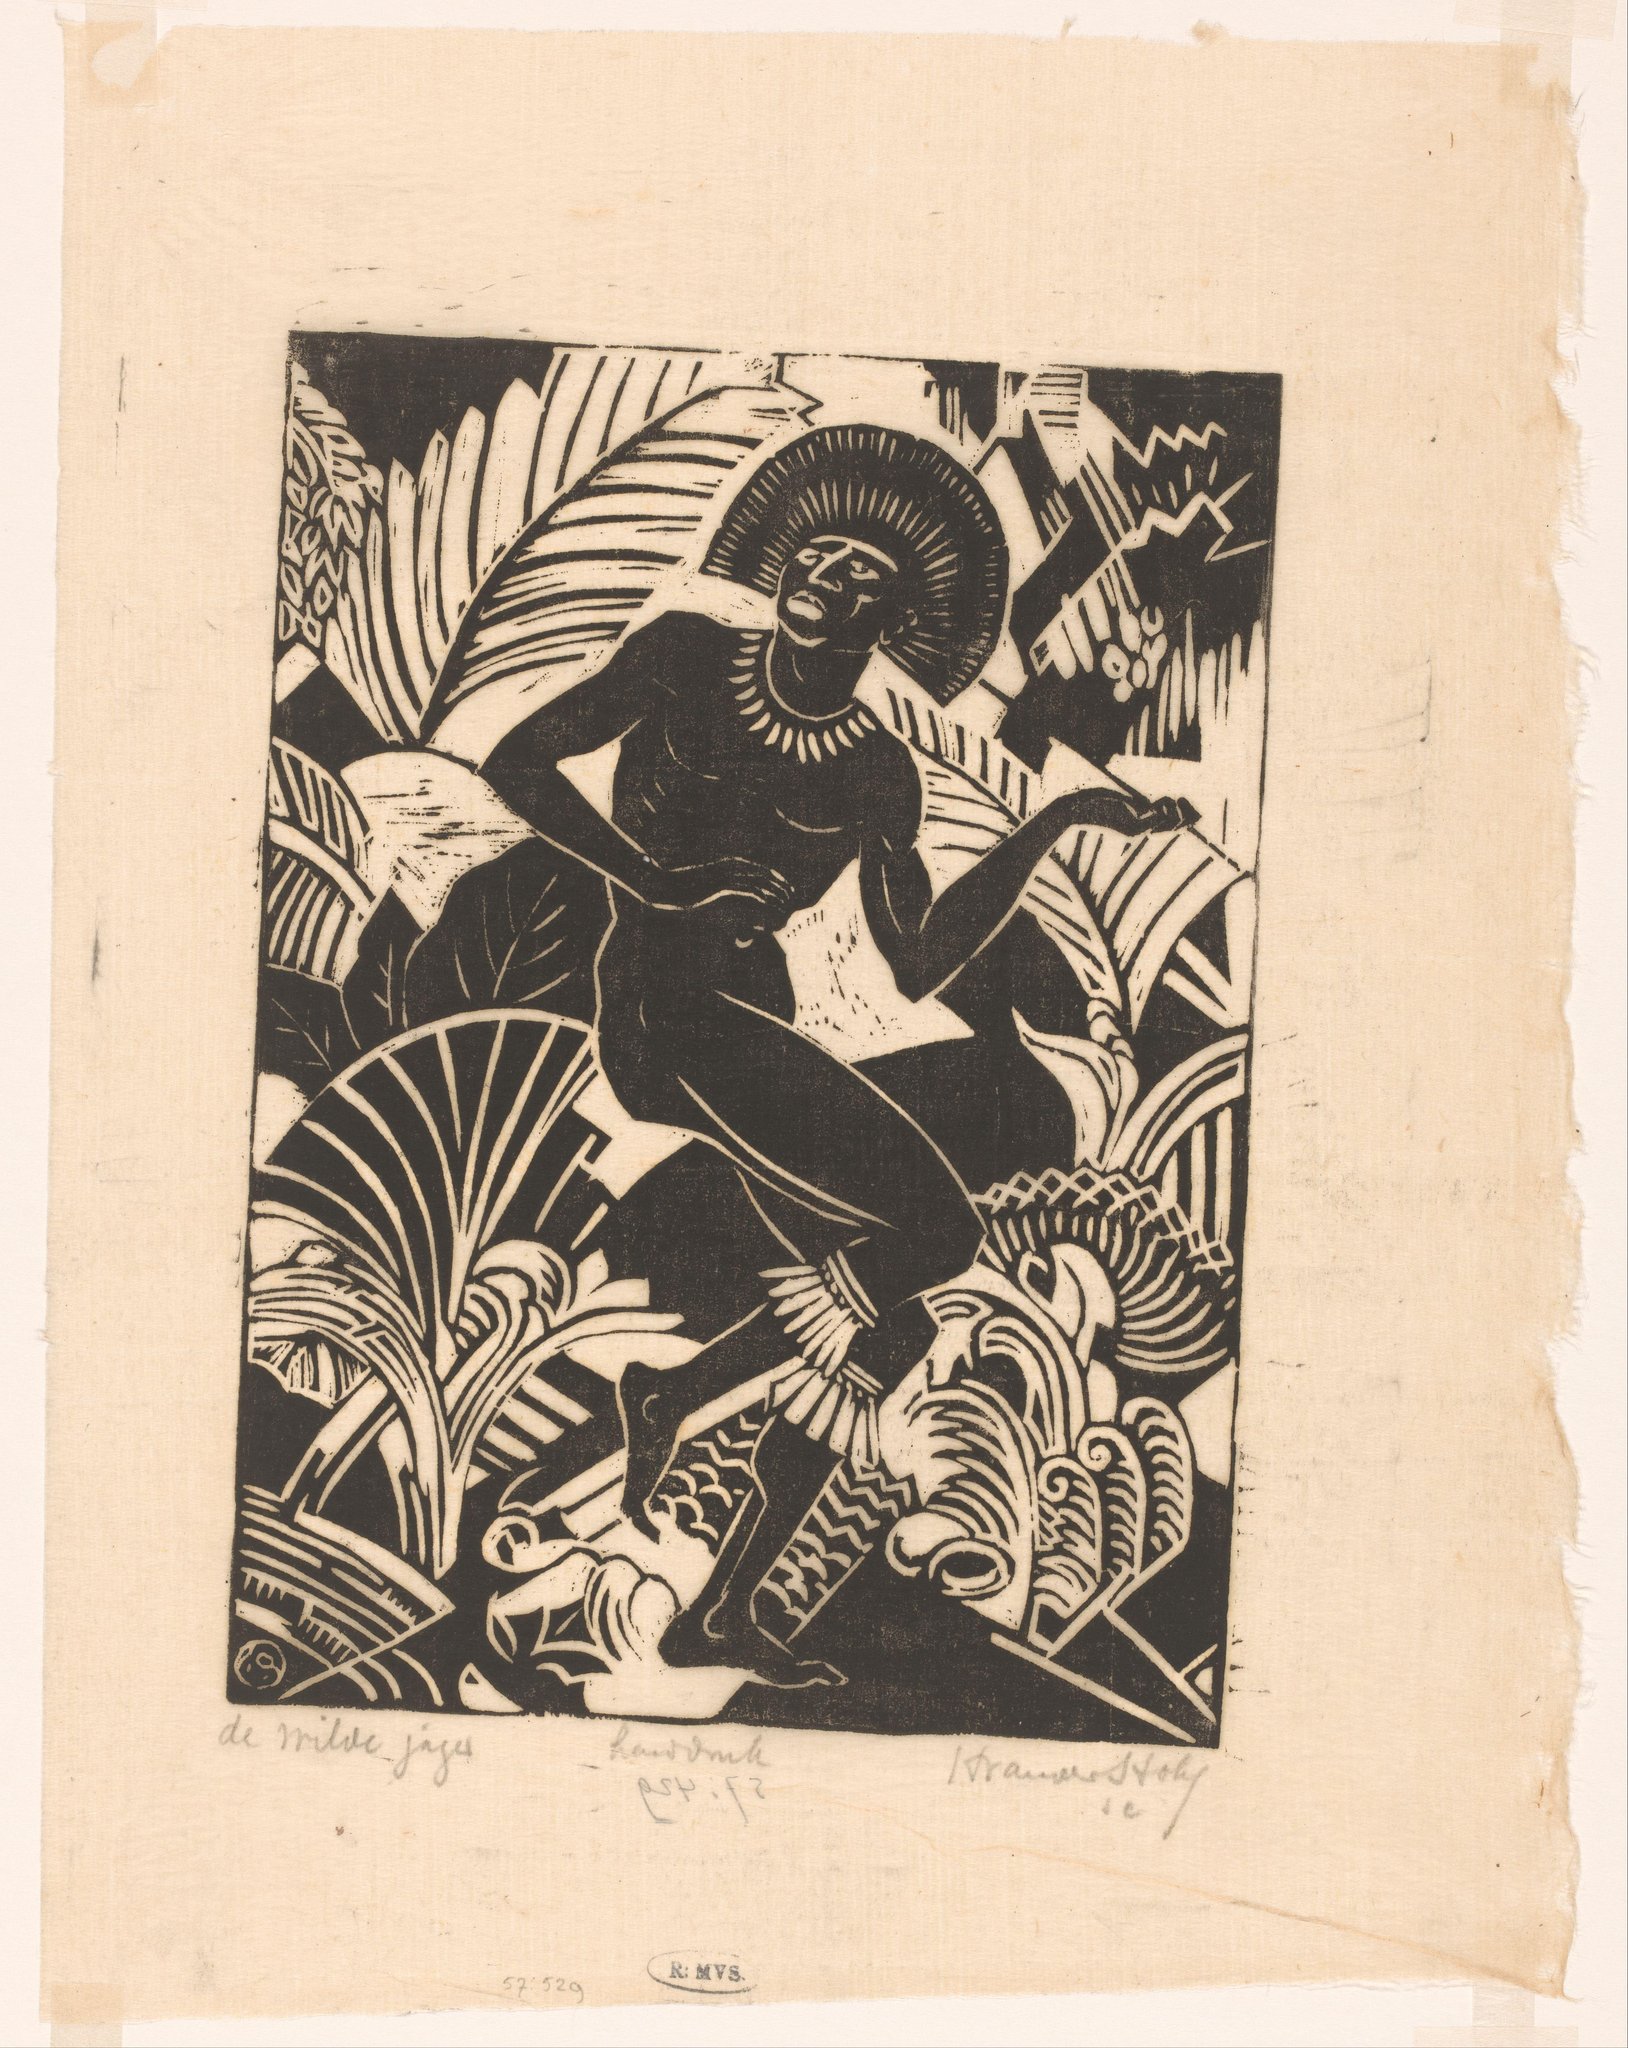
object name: print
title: Jager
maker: henri van der stok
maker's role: print maker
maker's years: 1870-1946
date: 1880-1946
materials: paper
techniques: woodcut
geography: netherlands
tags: africans, hunter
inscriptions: collector's mark: Lugt 2228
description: Een zwarte man met kroon op het hoofd staat gedraaid op één been tussen struikgewas. In zijn linkerhand houdt hij een speer of een pijl.